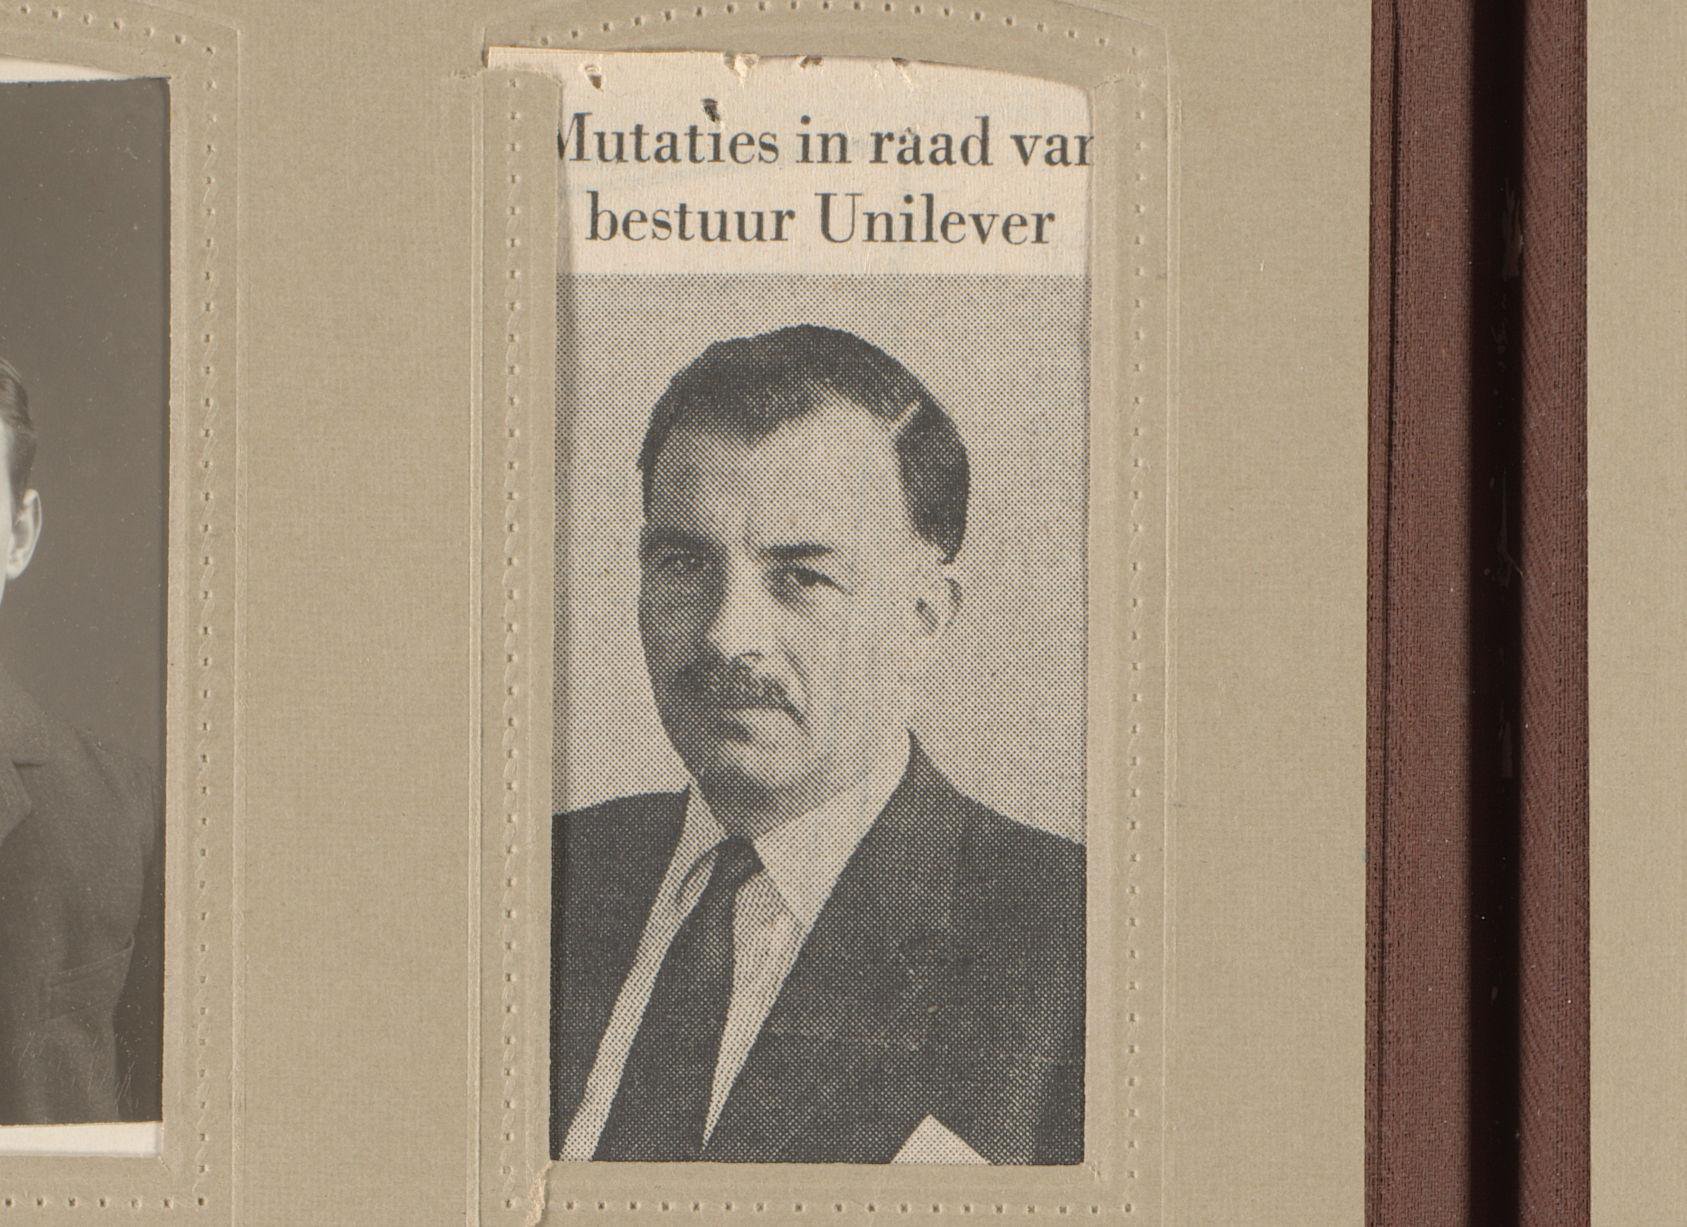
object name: photograph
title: Krantenartikel met foto van Mr. C.T.C. Heyning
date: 1910-1960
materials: paper, photographic support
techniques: autotype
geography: netherlands